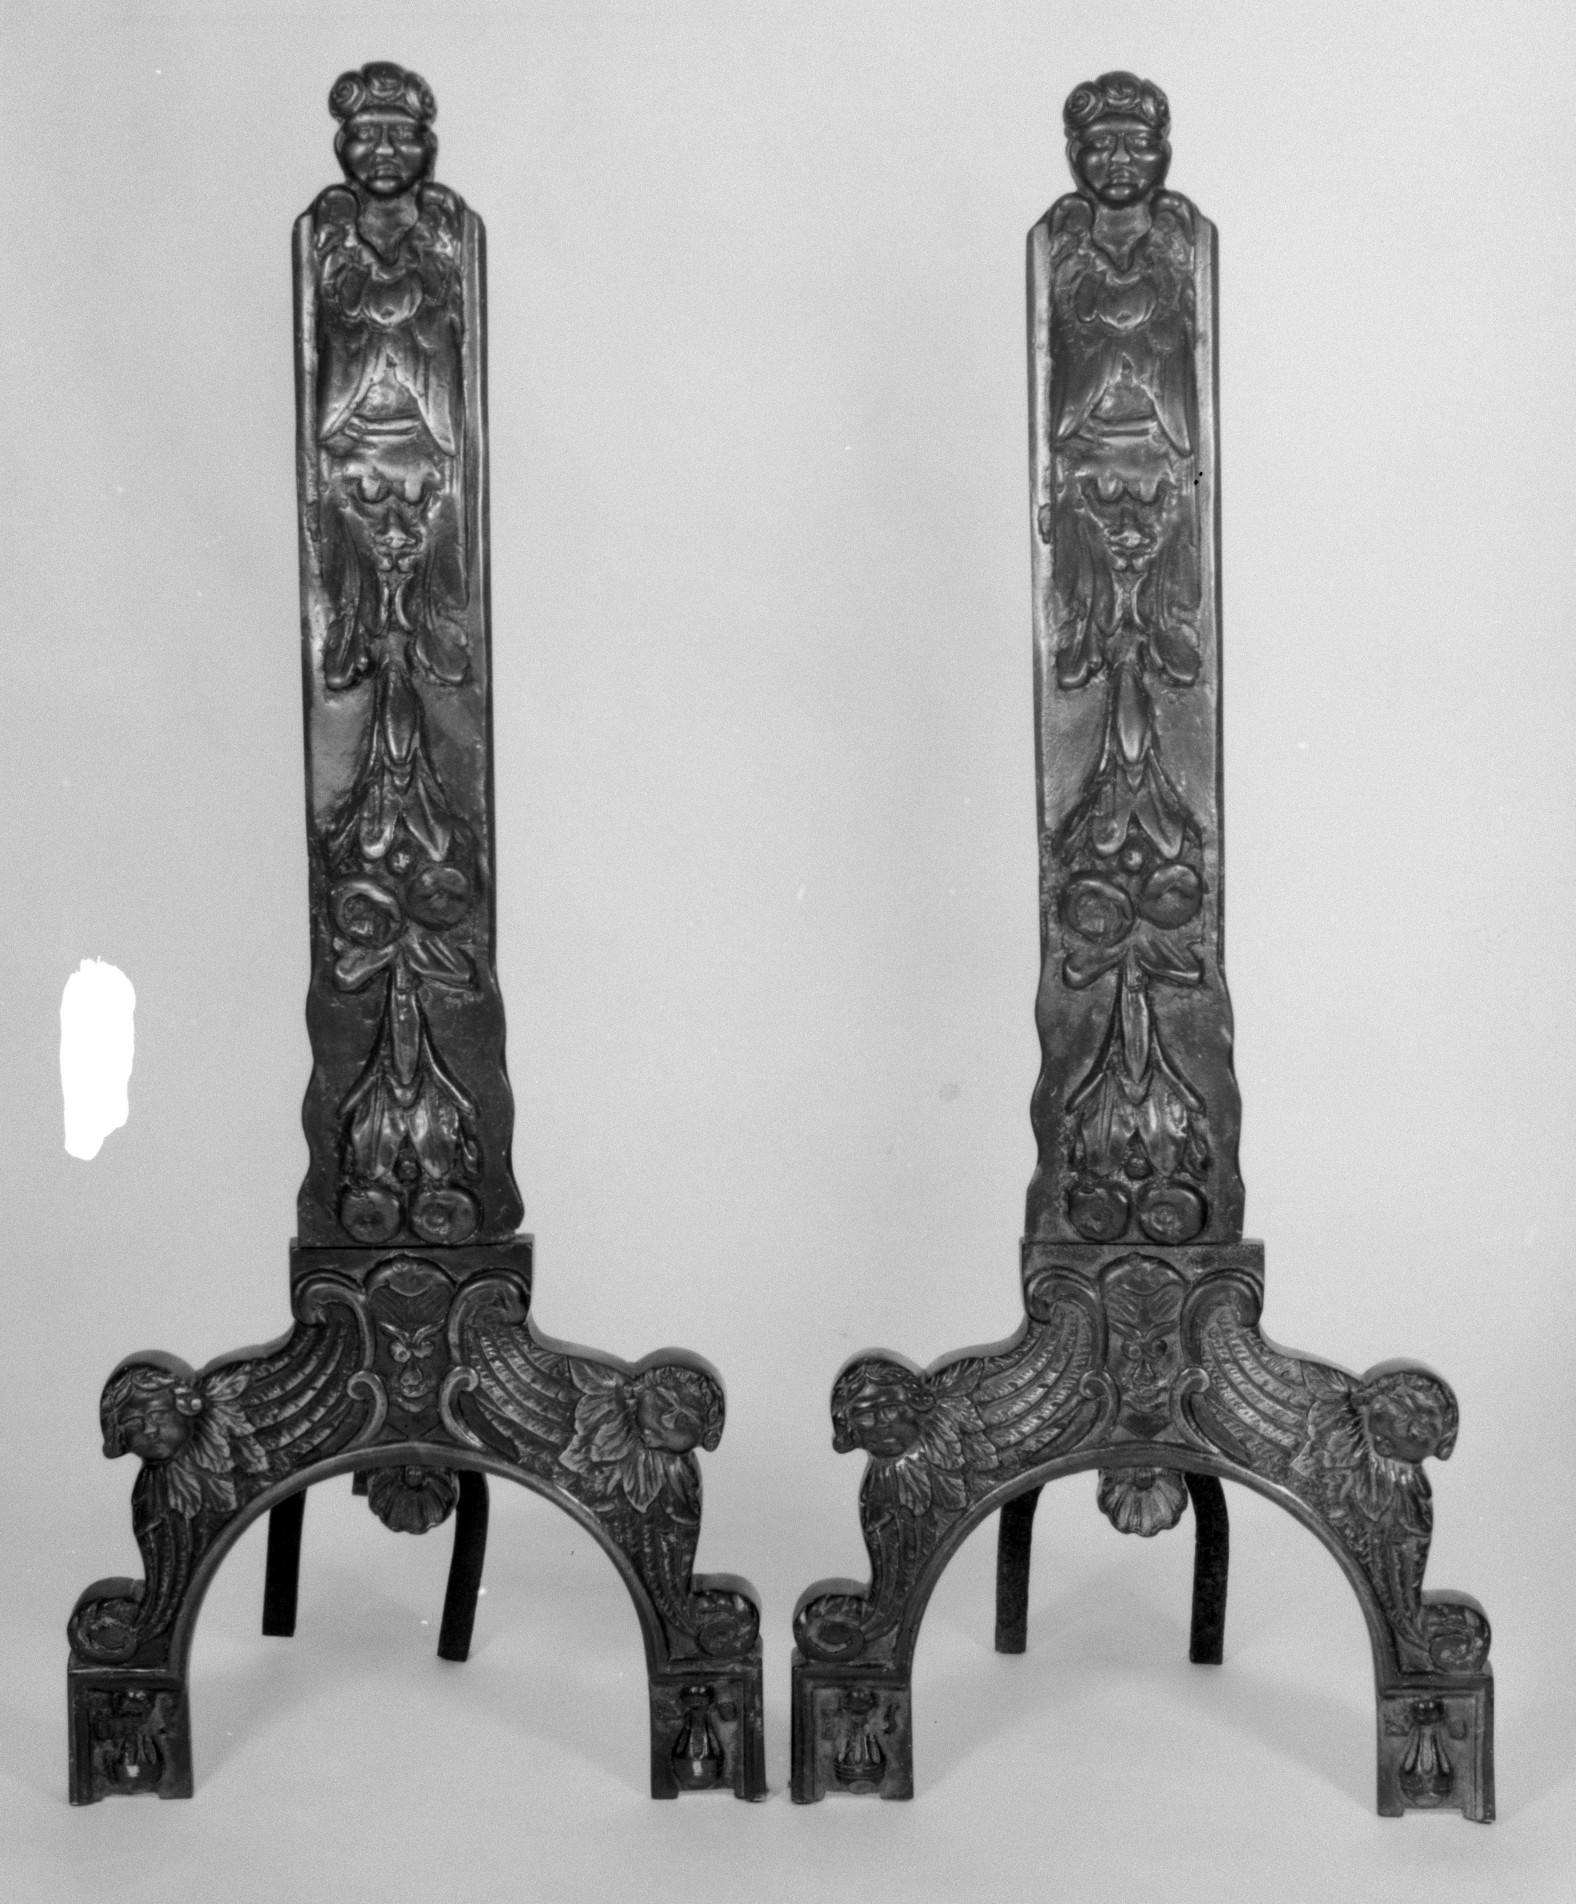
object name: andiron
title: Pair of andirons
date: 1601-1700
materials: bronze, iron